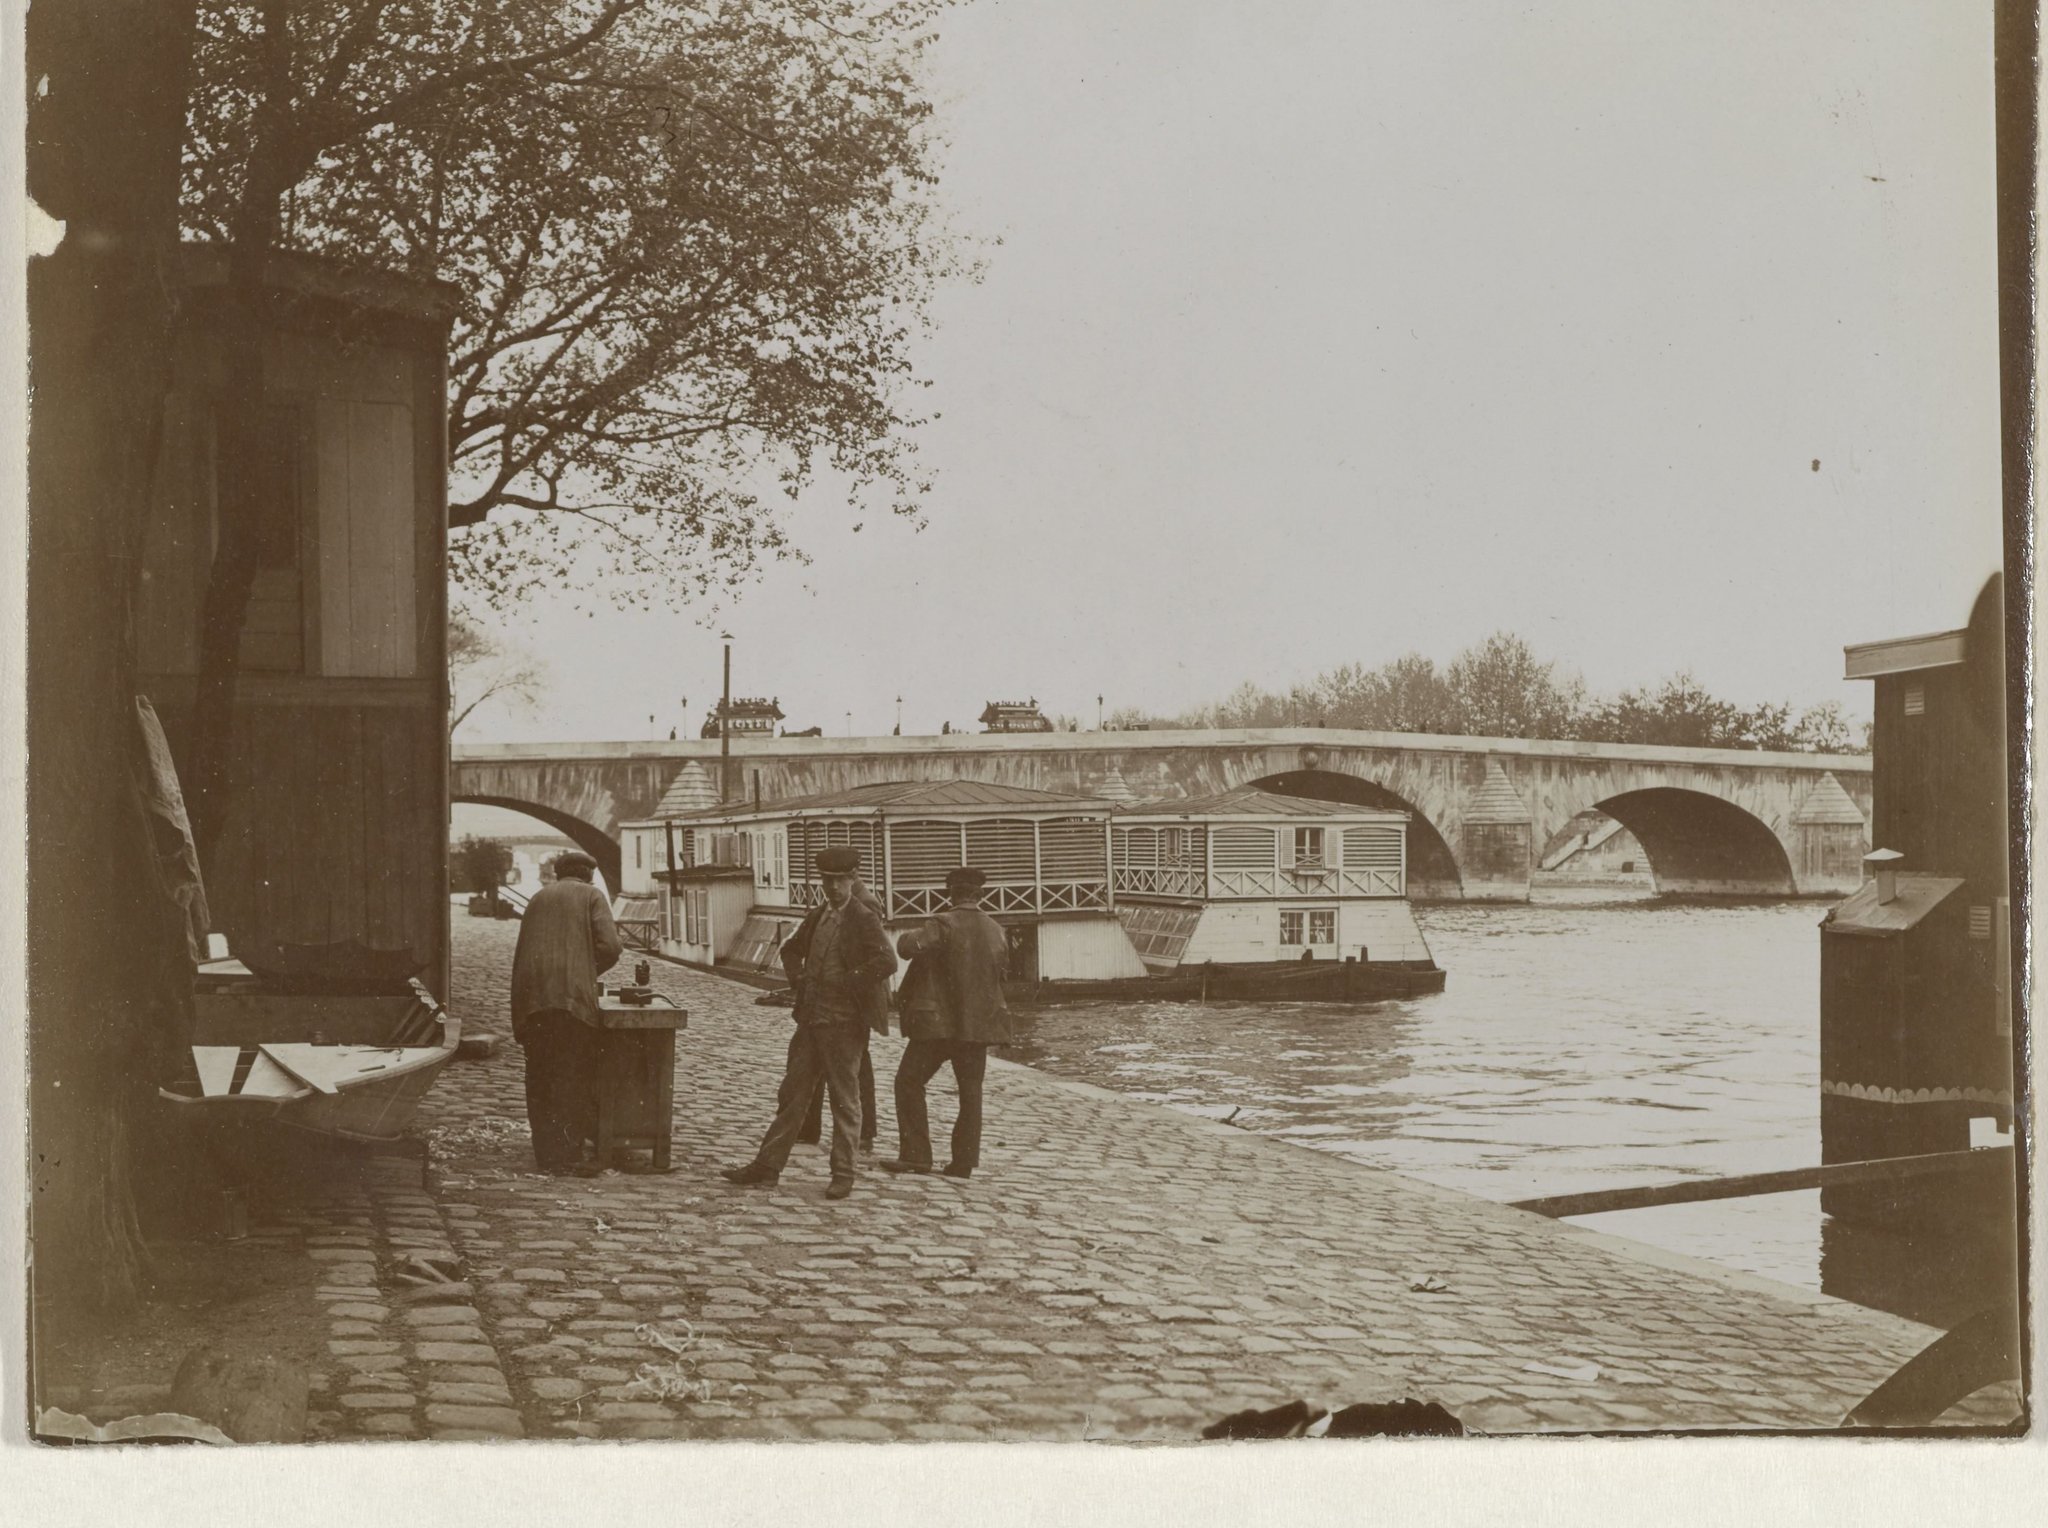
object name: photograph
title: Vier mannen op de kade bij de Pont Royal te Parijs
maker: Anonymous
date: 1900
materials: paper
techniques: collodion silver print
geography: paris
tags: quay, paris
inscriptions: inscription: ‘Bergs de la jeunie’